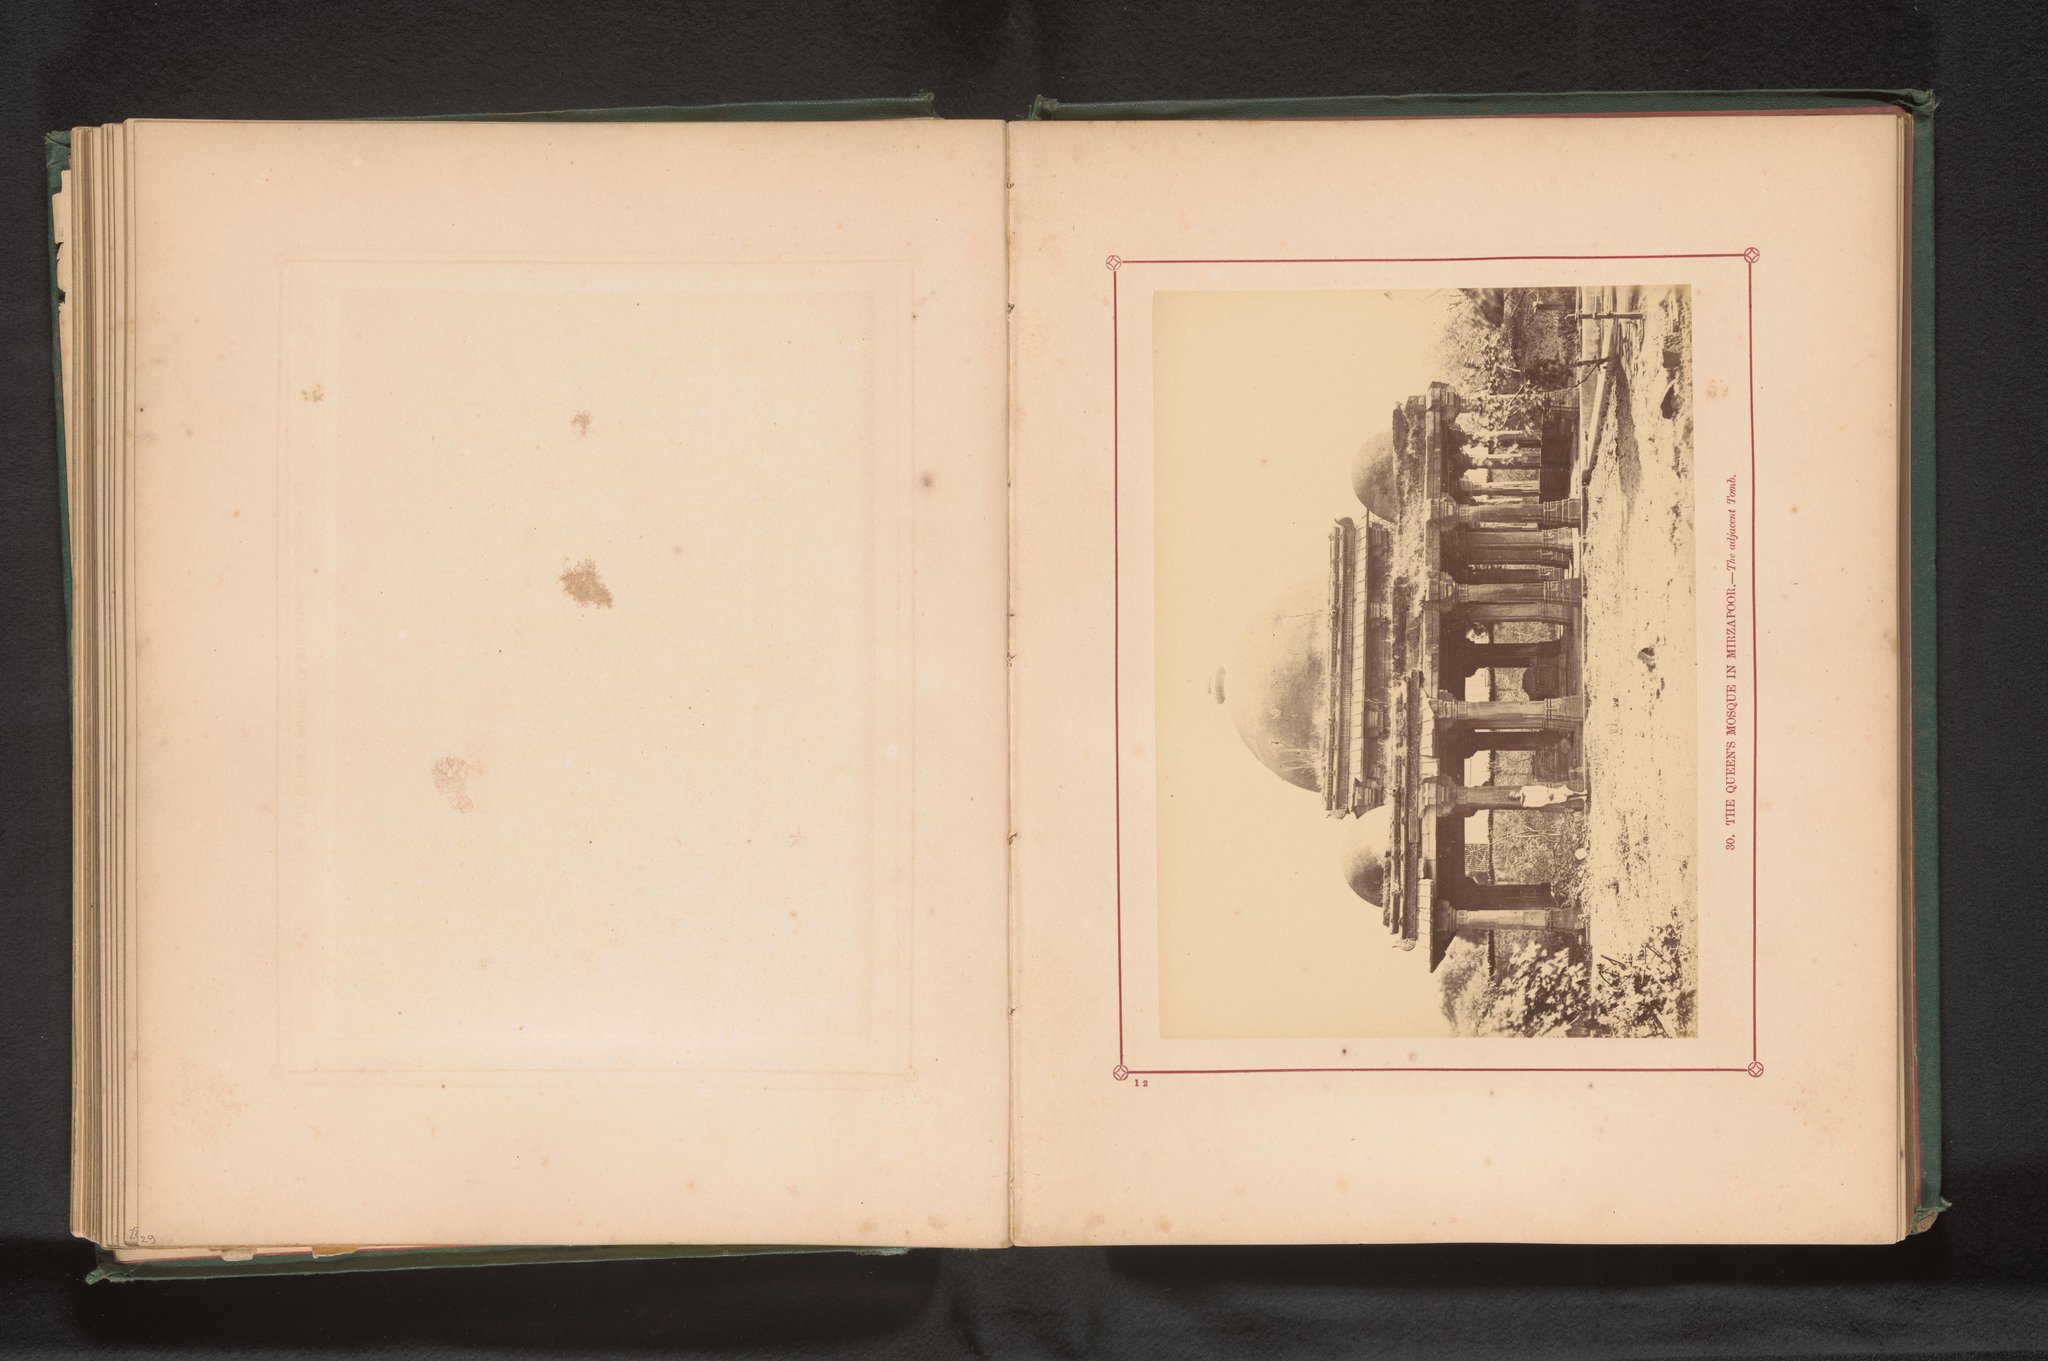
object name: photograph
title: Tombe vlakbij de Rani Rupamati-moskee in Ahmedabad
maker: thomas biggs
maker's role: fotograaf, kapitein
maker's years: 1822-1905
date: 1856-1866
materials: photographic support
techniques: albumen print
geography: ahmedabad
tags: grave, tomb, temple, shrine ~ islam, mohammedanism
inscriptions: inscription: ‘I2’, number: ‘30.’